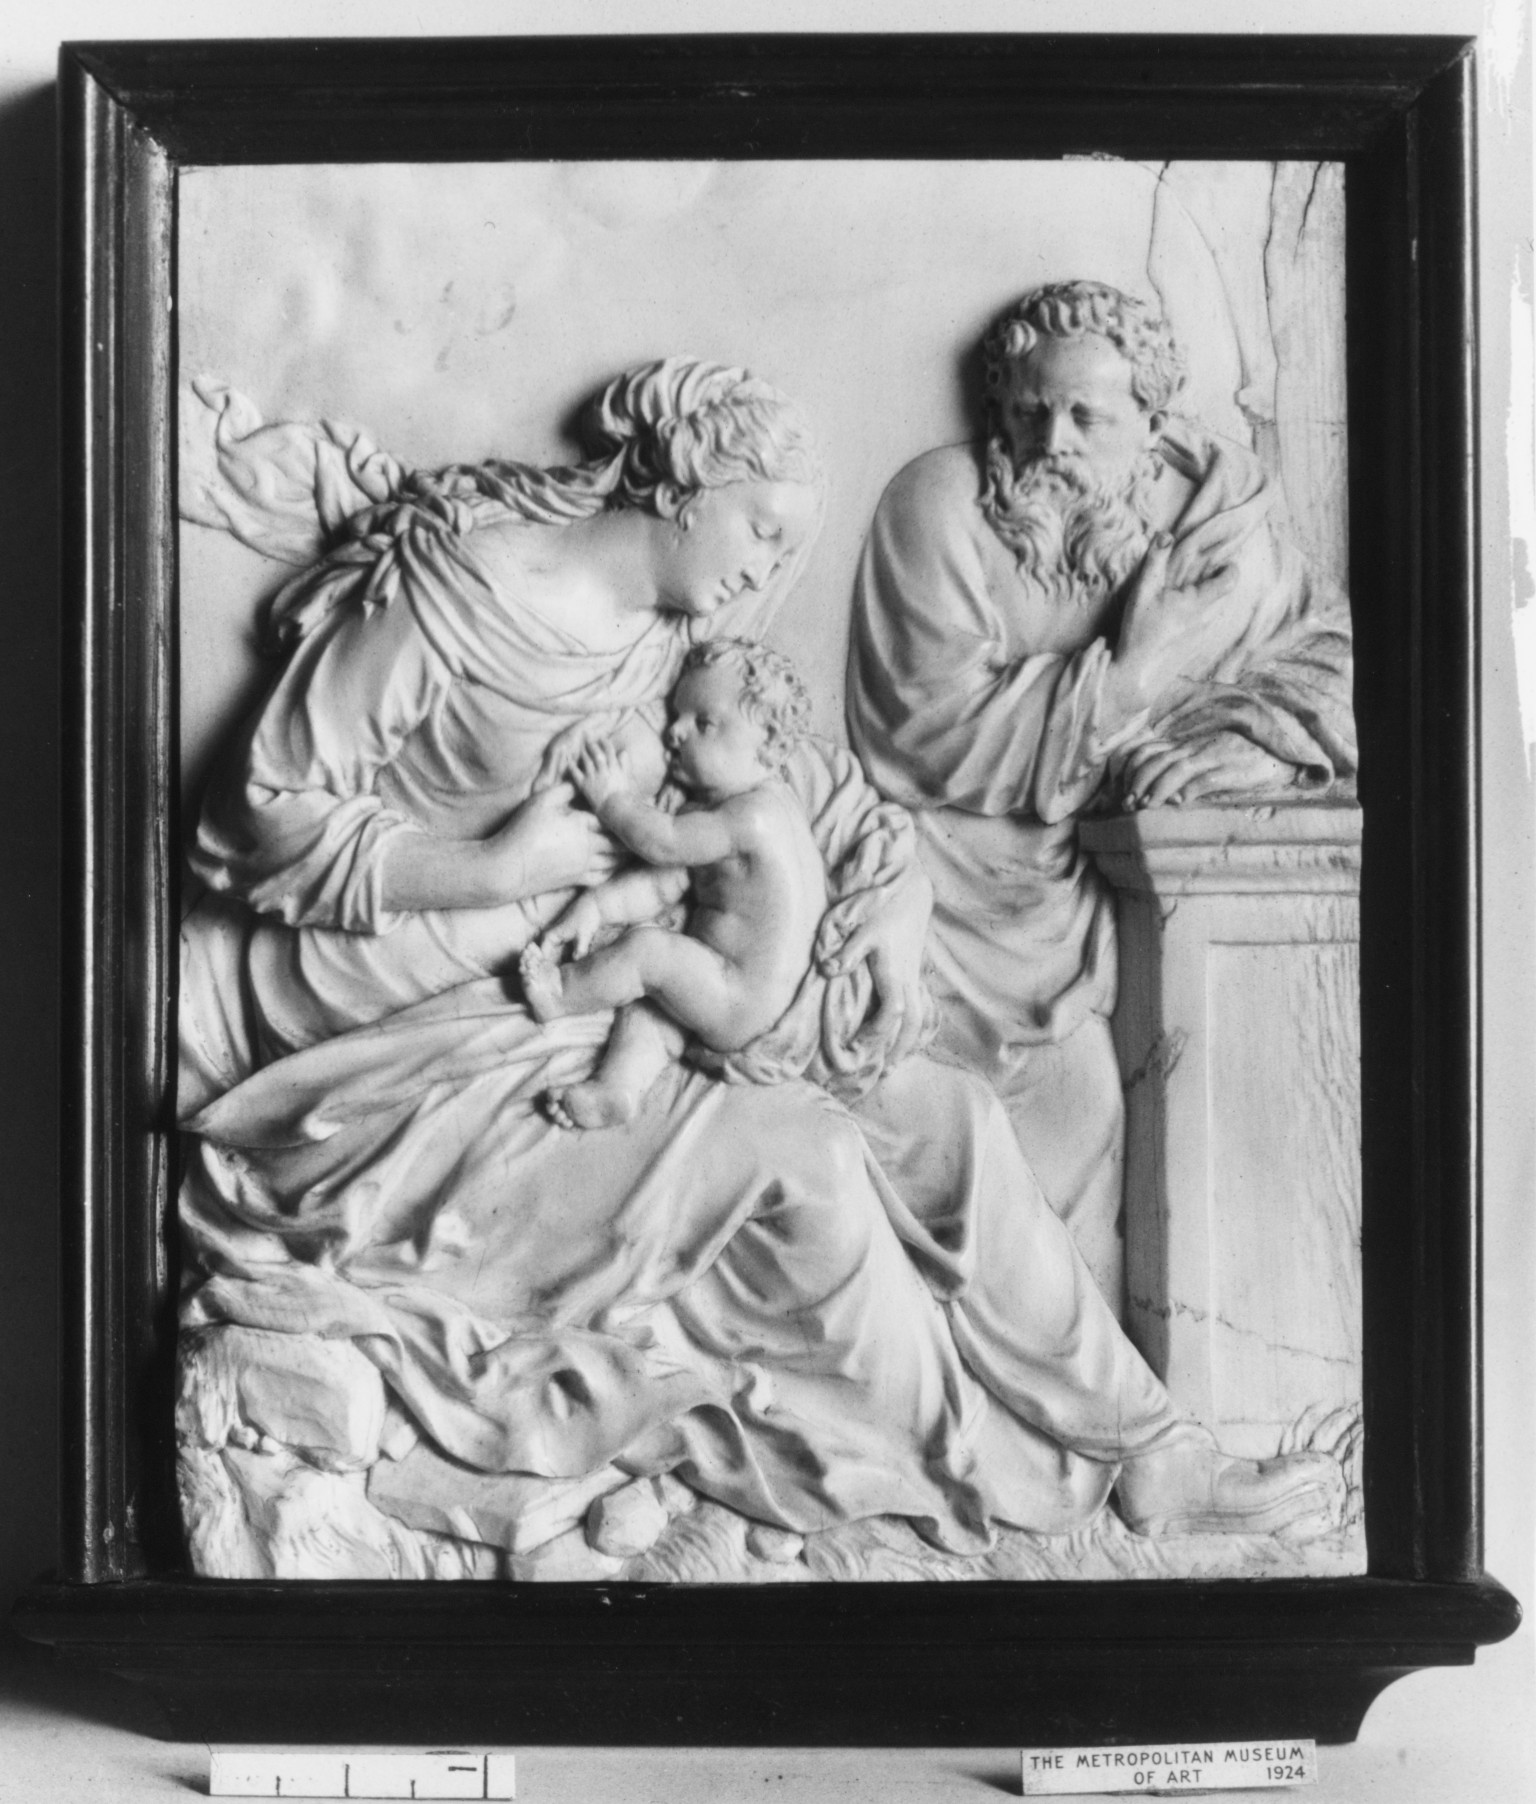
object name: plaque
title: The Holy Family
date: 1701-1733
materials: ivory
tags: christ,holy family,saint joseph,virgin mary